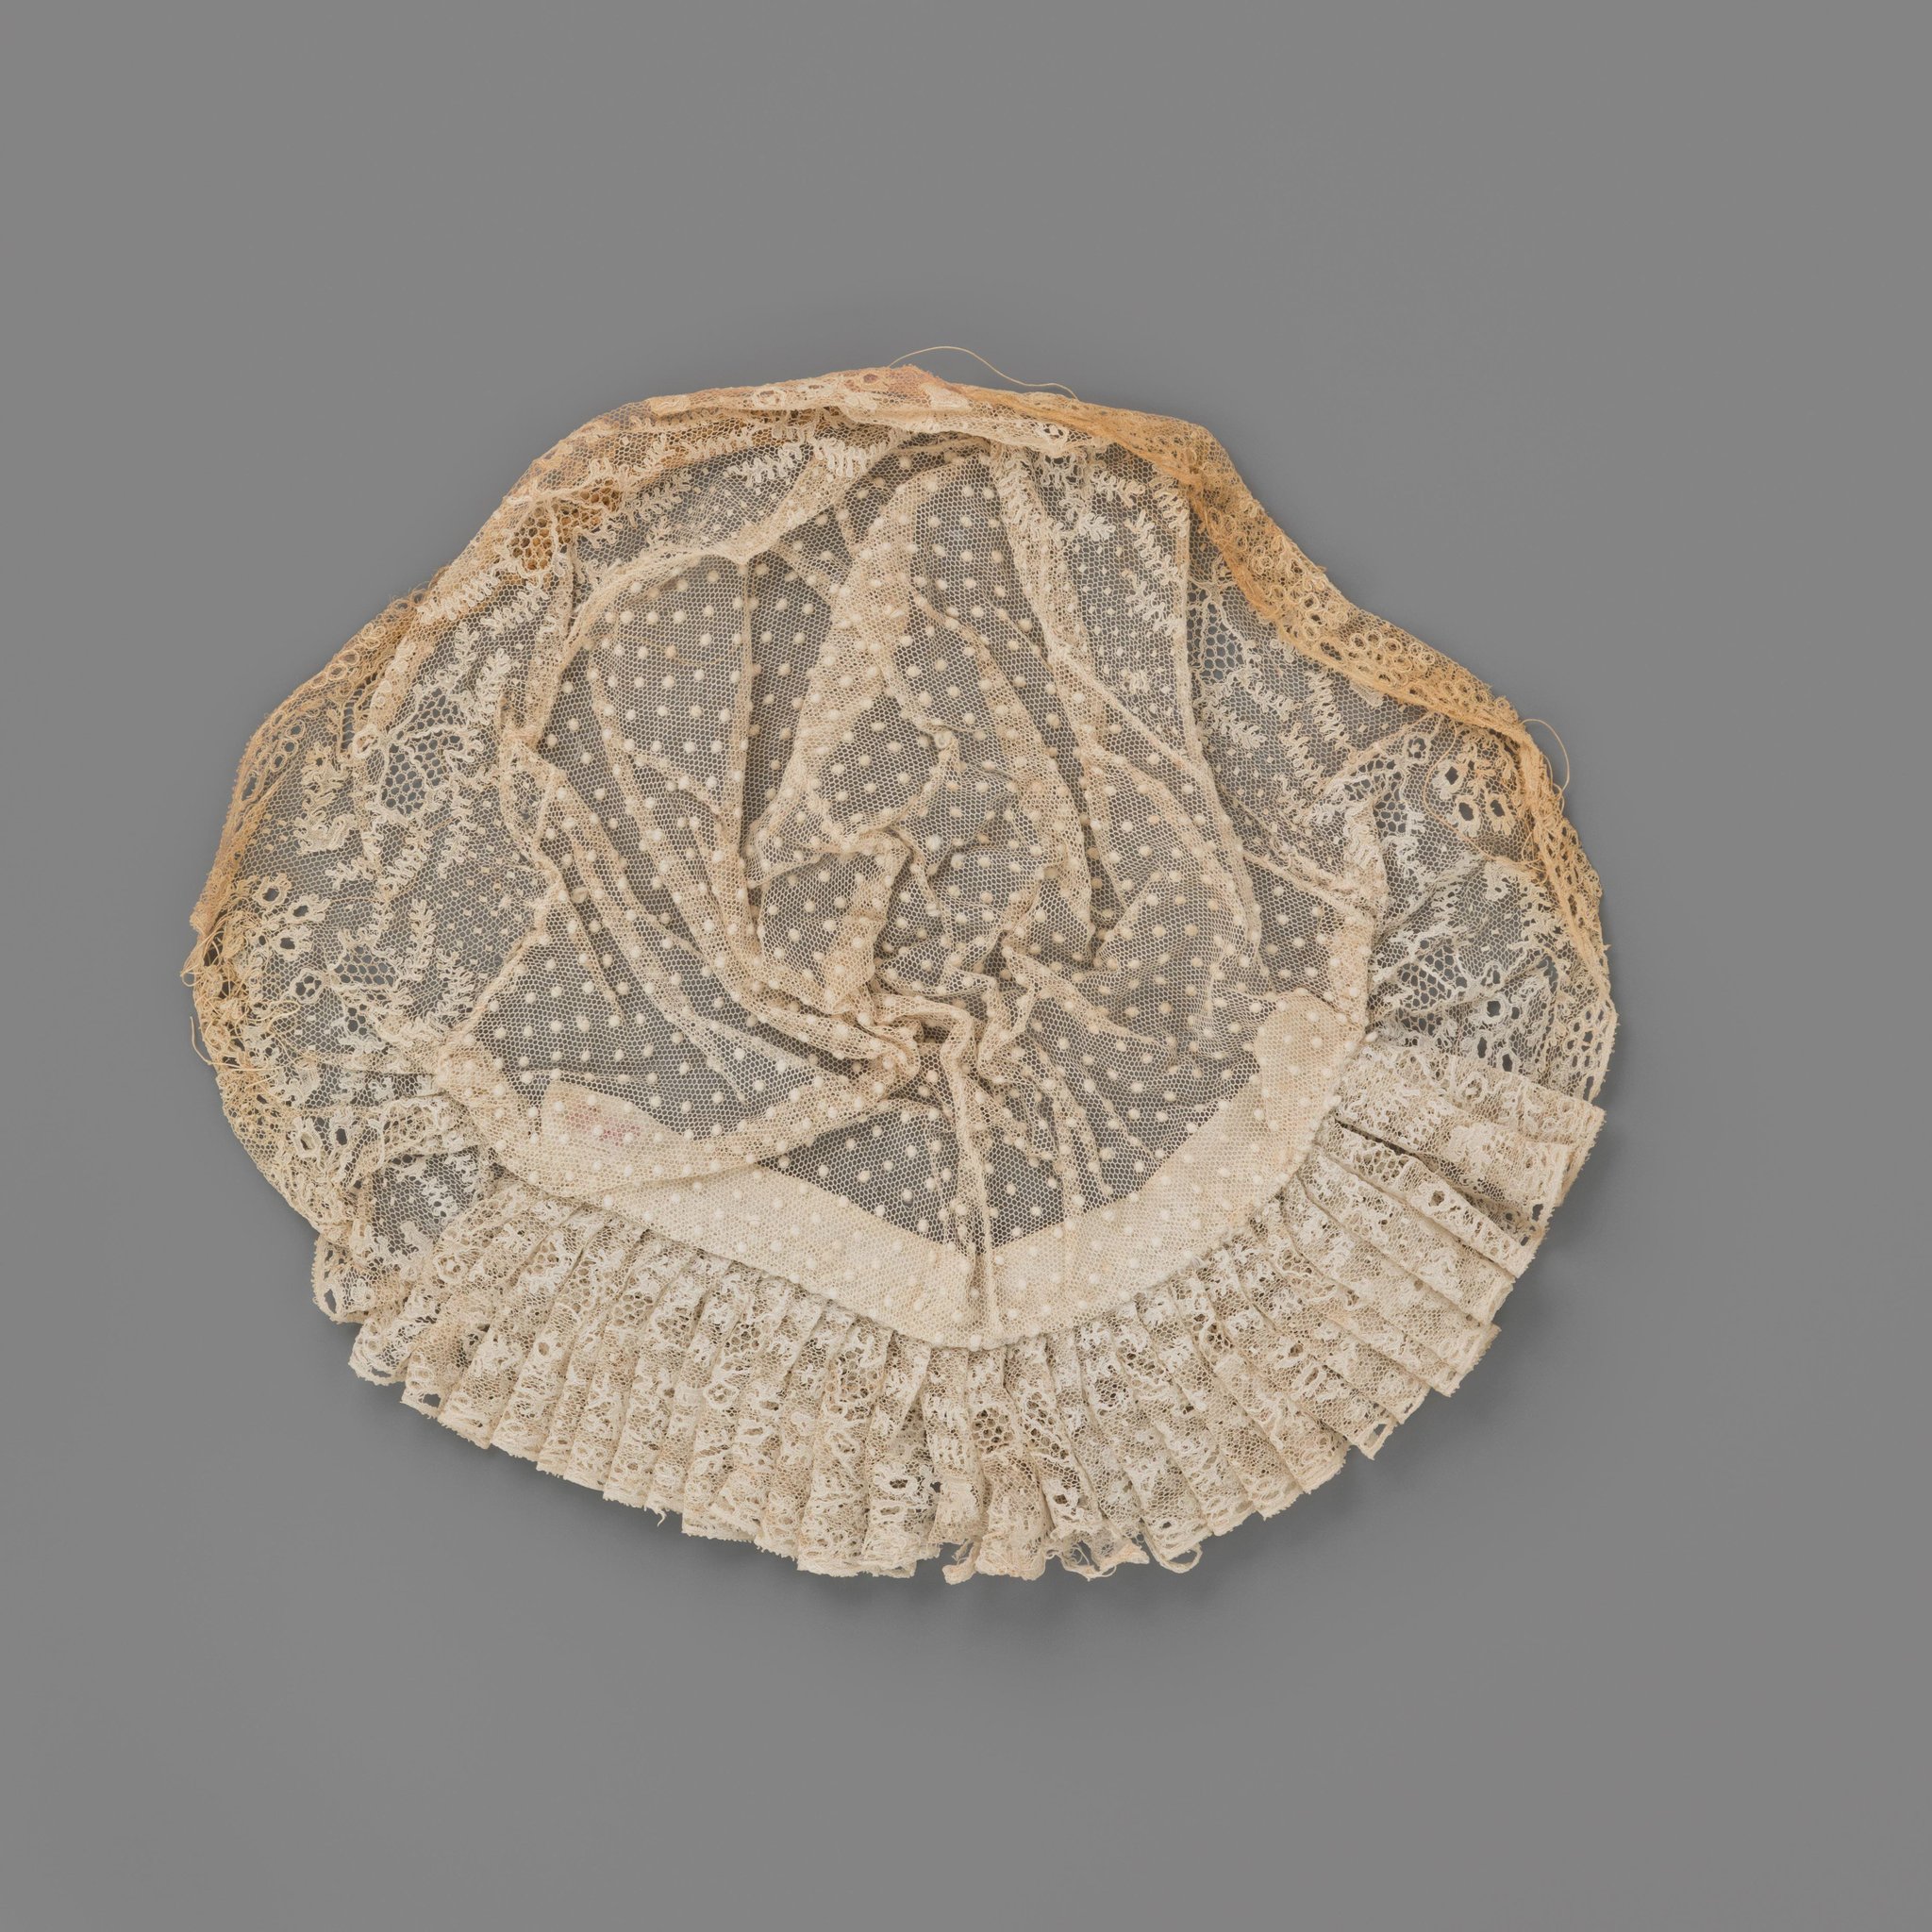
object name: streekdracht, streekkleding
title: Muts van tule met Rijsselse kant; be bol bestaat uit met moesjes geborduurde tule dat langs het voorhoofd is afgezet met een strook Rijsselse kant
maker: Anonymous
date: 1800-1900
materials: linen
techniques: material, embroidered, lace, weave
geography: lille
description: Muts van tule met Rijsselse kant. De bol bestaat uit met moesjes geborduurde tule. De bol is afgezet met een strook Rijsselse kant dat langs het voorhoofd geplooid is.